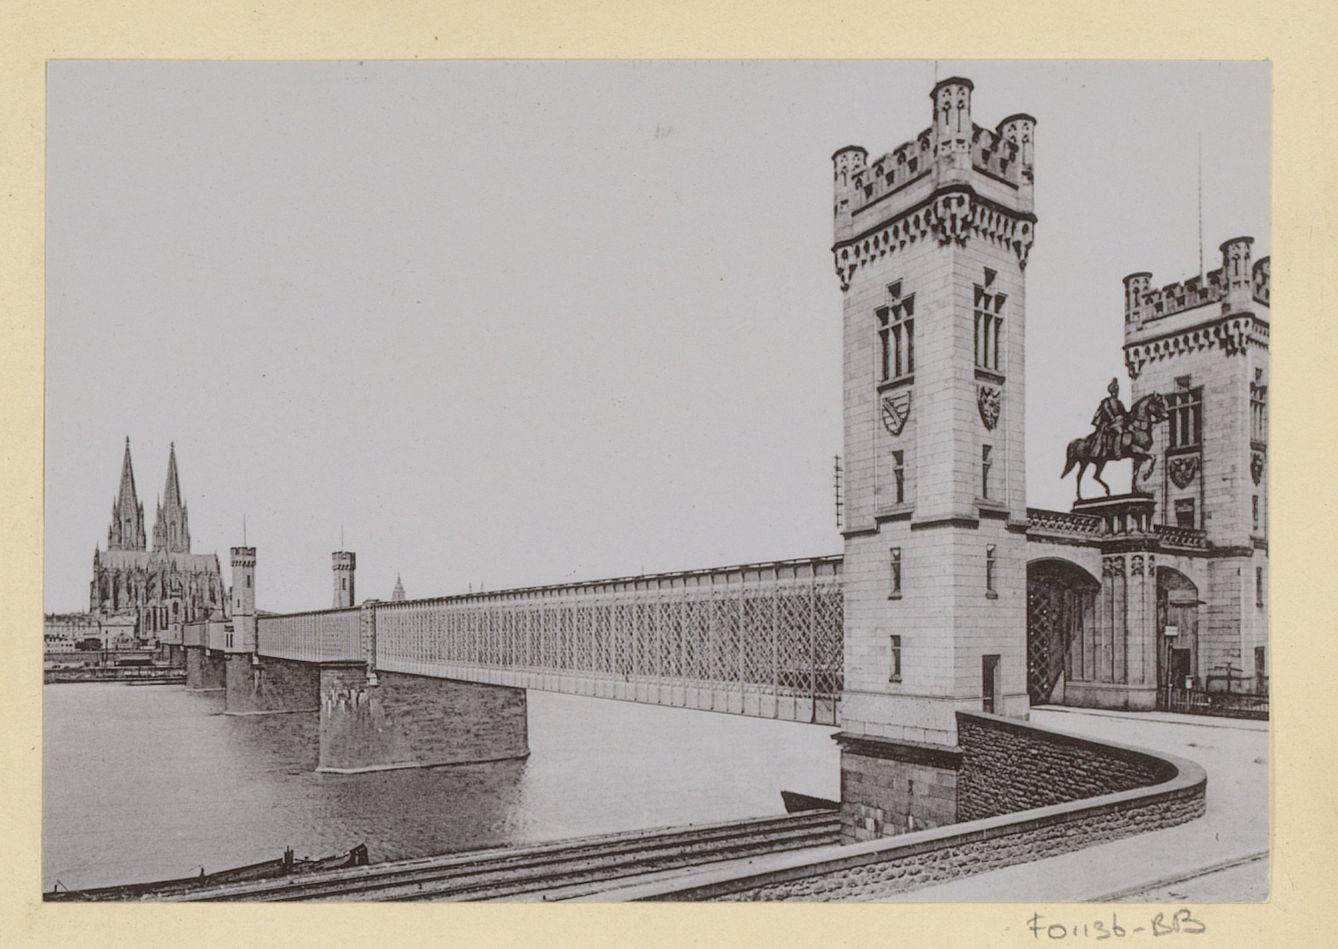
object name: photomechanical print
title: Dombrücke in Keulen gezien richting Dom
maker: Anonymous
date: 1880-1895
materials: paper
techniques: photograph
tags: railway, train, equestrian statue, bridge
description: Onderdeel van Fotoalbum met opnames van bezienswaardigheden in België, Duitsland en Noorwegen.